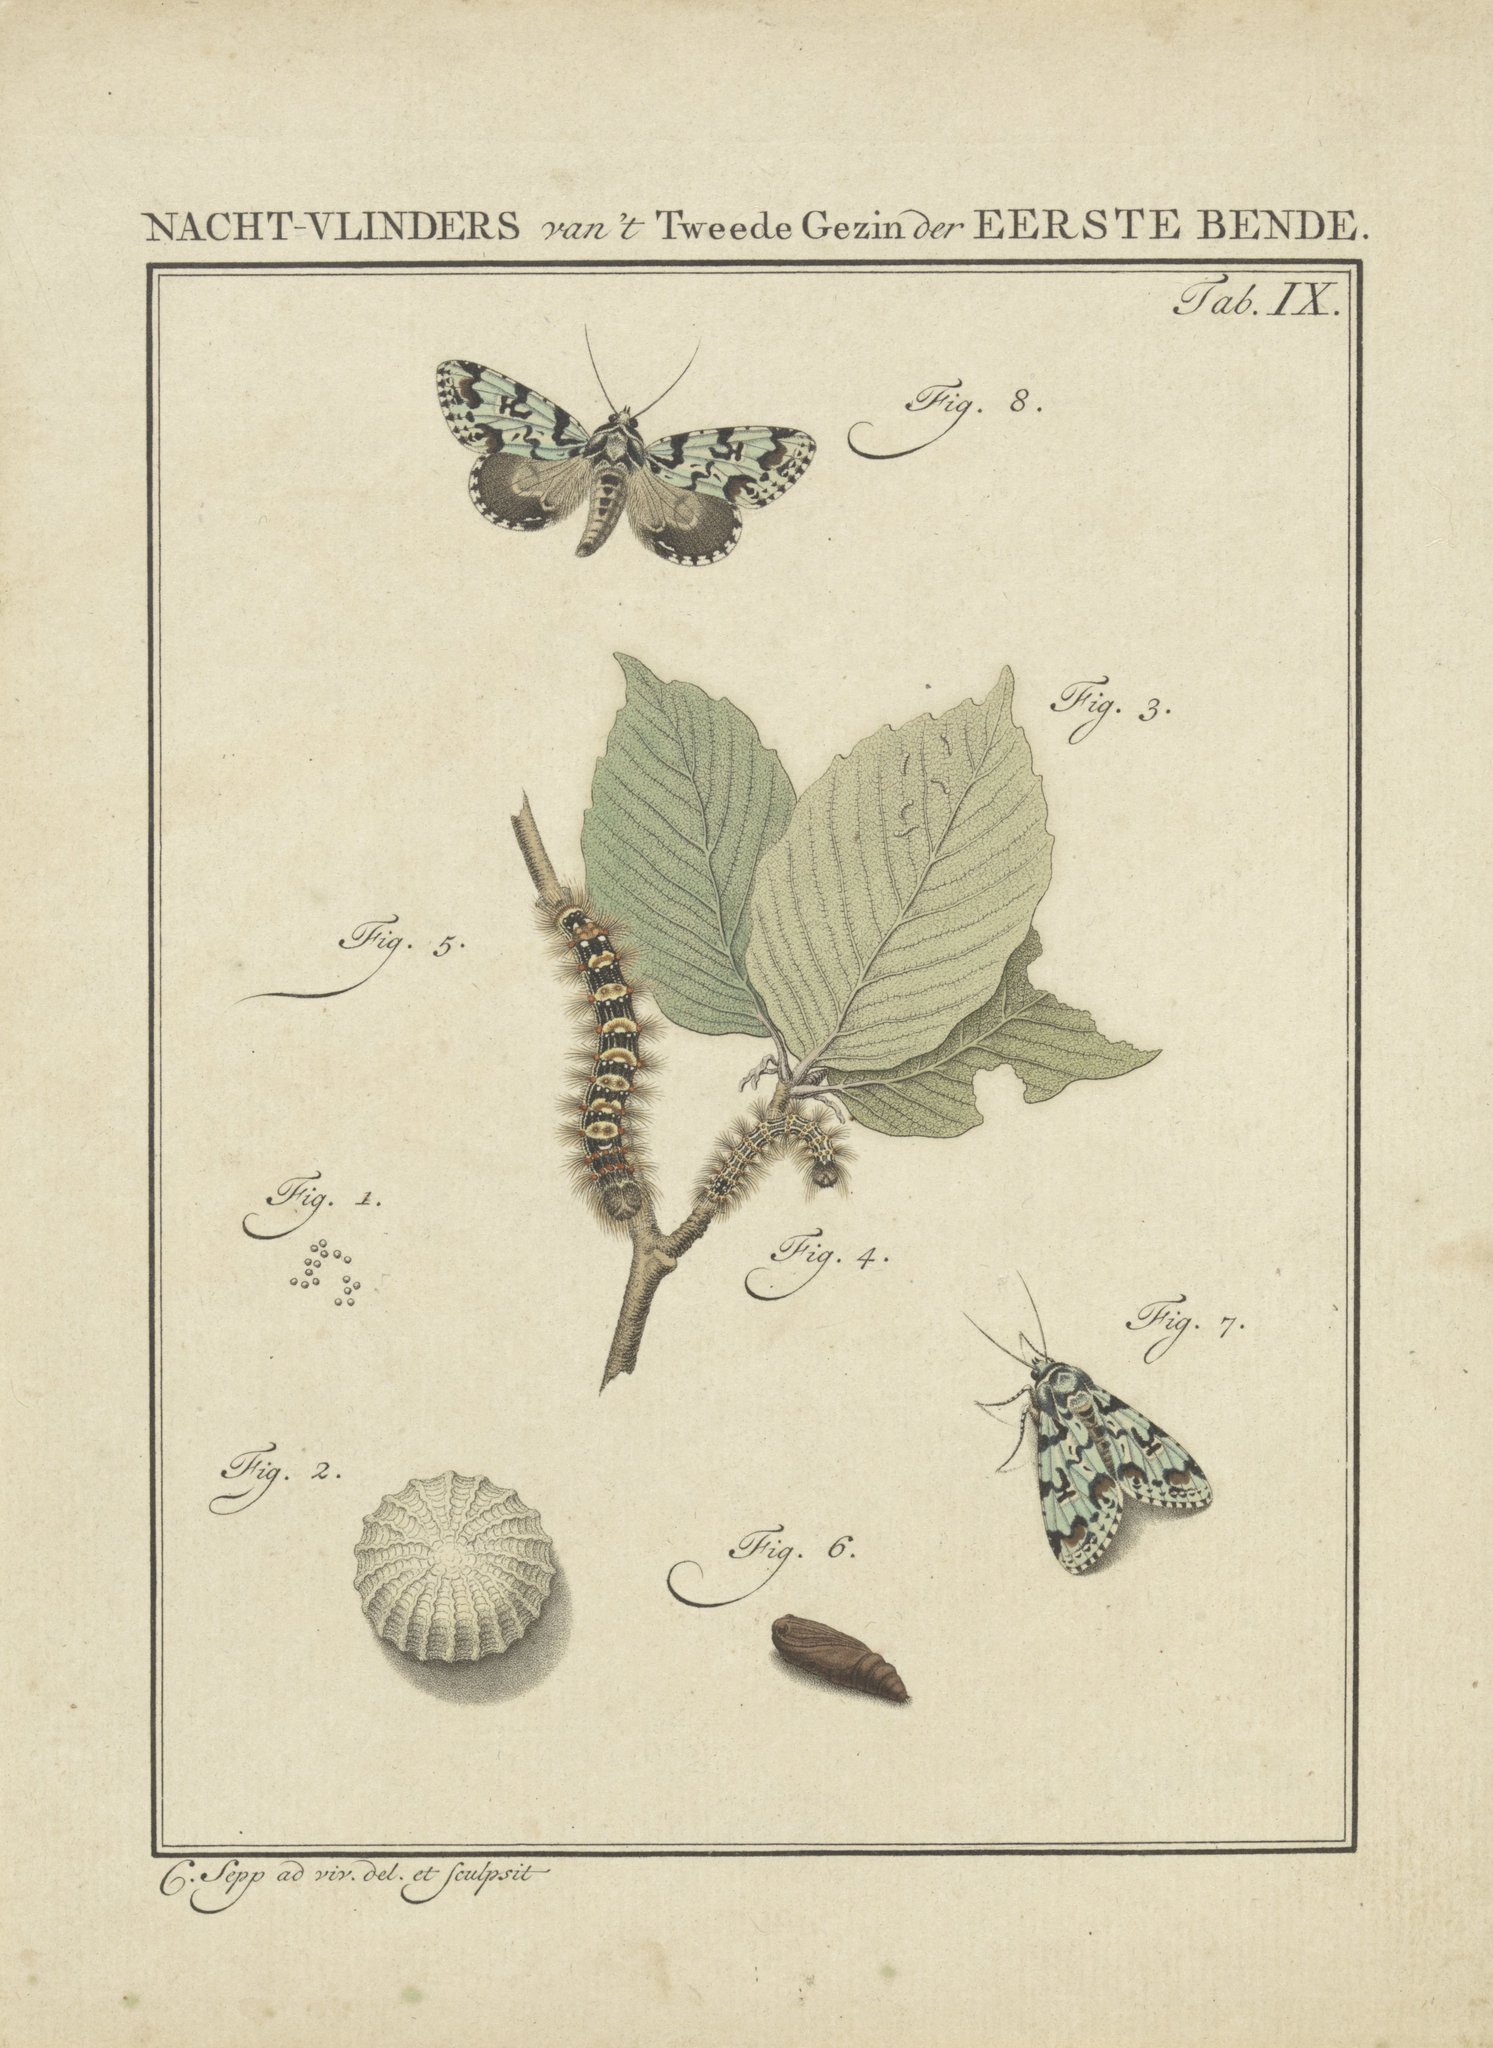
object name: book illustration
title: Nacht-vlinders van ´t Tweede Gezin der Eerste Bende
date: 1762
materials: paper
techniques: etching, hand coloring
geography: amsterdam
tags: insects: butterfly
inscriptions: collector's mark: Lugt 2228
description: Prent uit: Sepp, Jan Christiaan. Beschouwing der wonderen Gods, in de minstgeachte schepzelen. Of Nederlandsche insecten, naar hunne (...) byzonderheden (...) beschreeven. Amsterdam: Jan Christiaan Sepp, 1762, dl. 1, na p. 44.